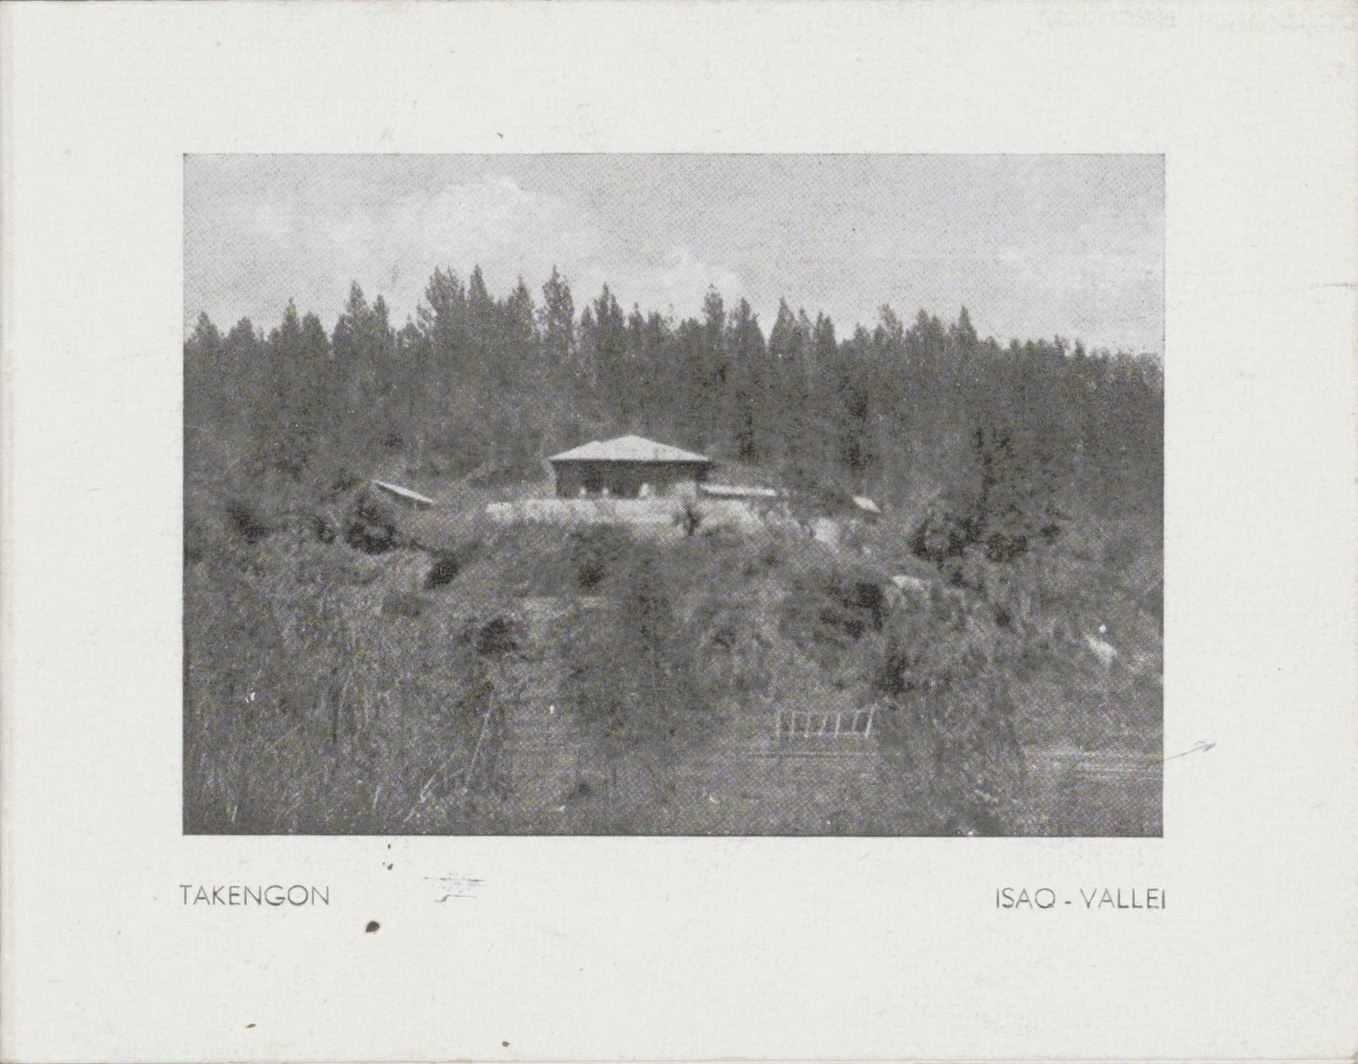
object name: photograph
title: Voorzijde van de geboortekaart van Anton Eduard, geboren 6 maart 1940 op het Gouv. Hars-en Terpentijnbedrijf te Takengon, als zoon van J.E. Dinger en E. Dinger-Krol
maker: Anonymous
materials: paper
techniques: autotype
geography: sumatra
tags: further education (+ pupil), further education, rural housing, e.g. country-house, villa, cottage, confinement, birth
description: Onderdeel van Stamboek van de leerlingen der Koloniale School voor Meisjes en Vrouwen te 's-Gravenhage deel II (1930-1949).